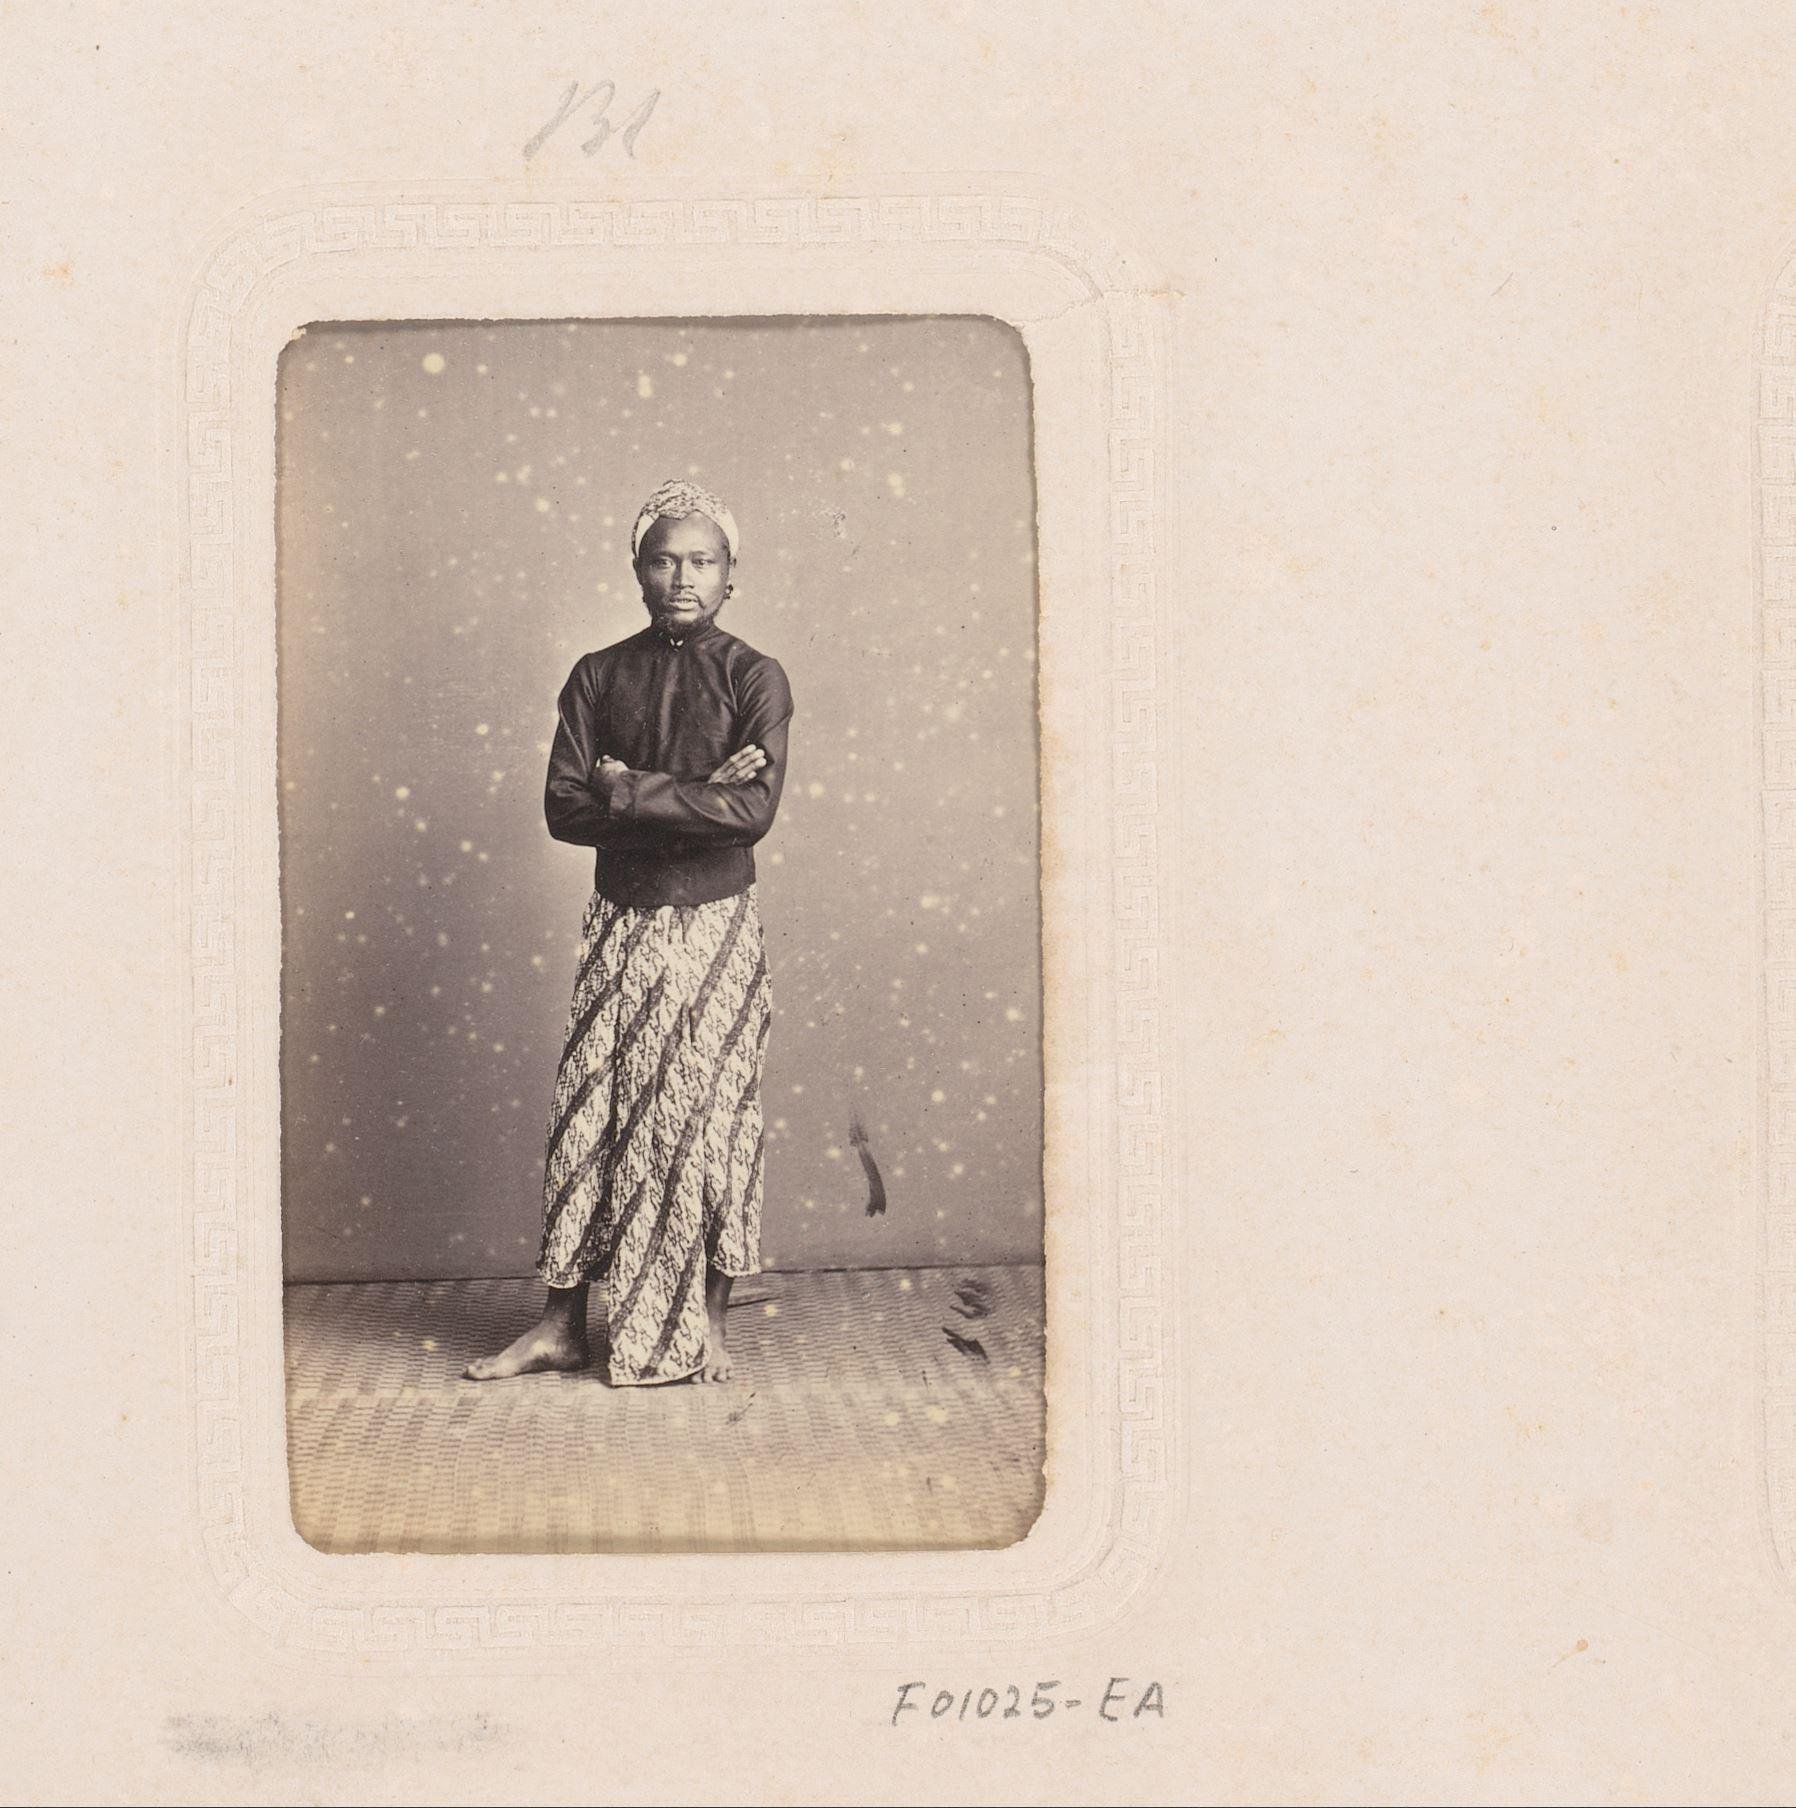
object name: carte de visite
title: Portret van een staande Indonesische man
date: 1857-1880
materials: cardboard, photographic support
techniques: albumen print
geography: java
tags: historical persons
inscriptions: inscription: ‘Woodbury & Page/ Photographers/ Java’, number: ‘131’